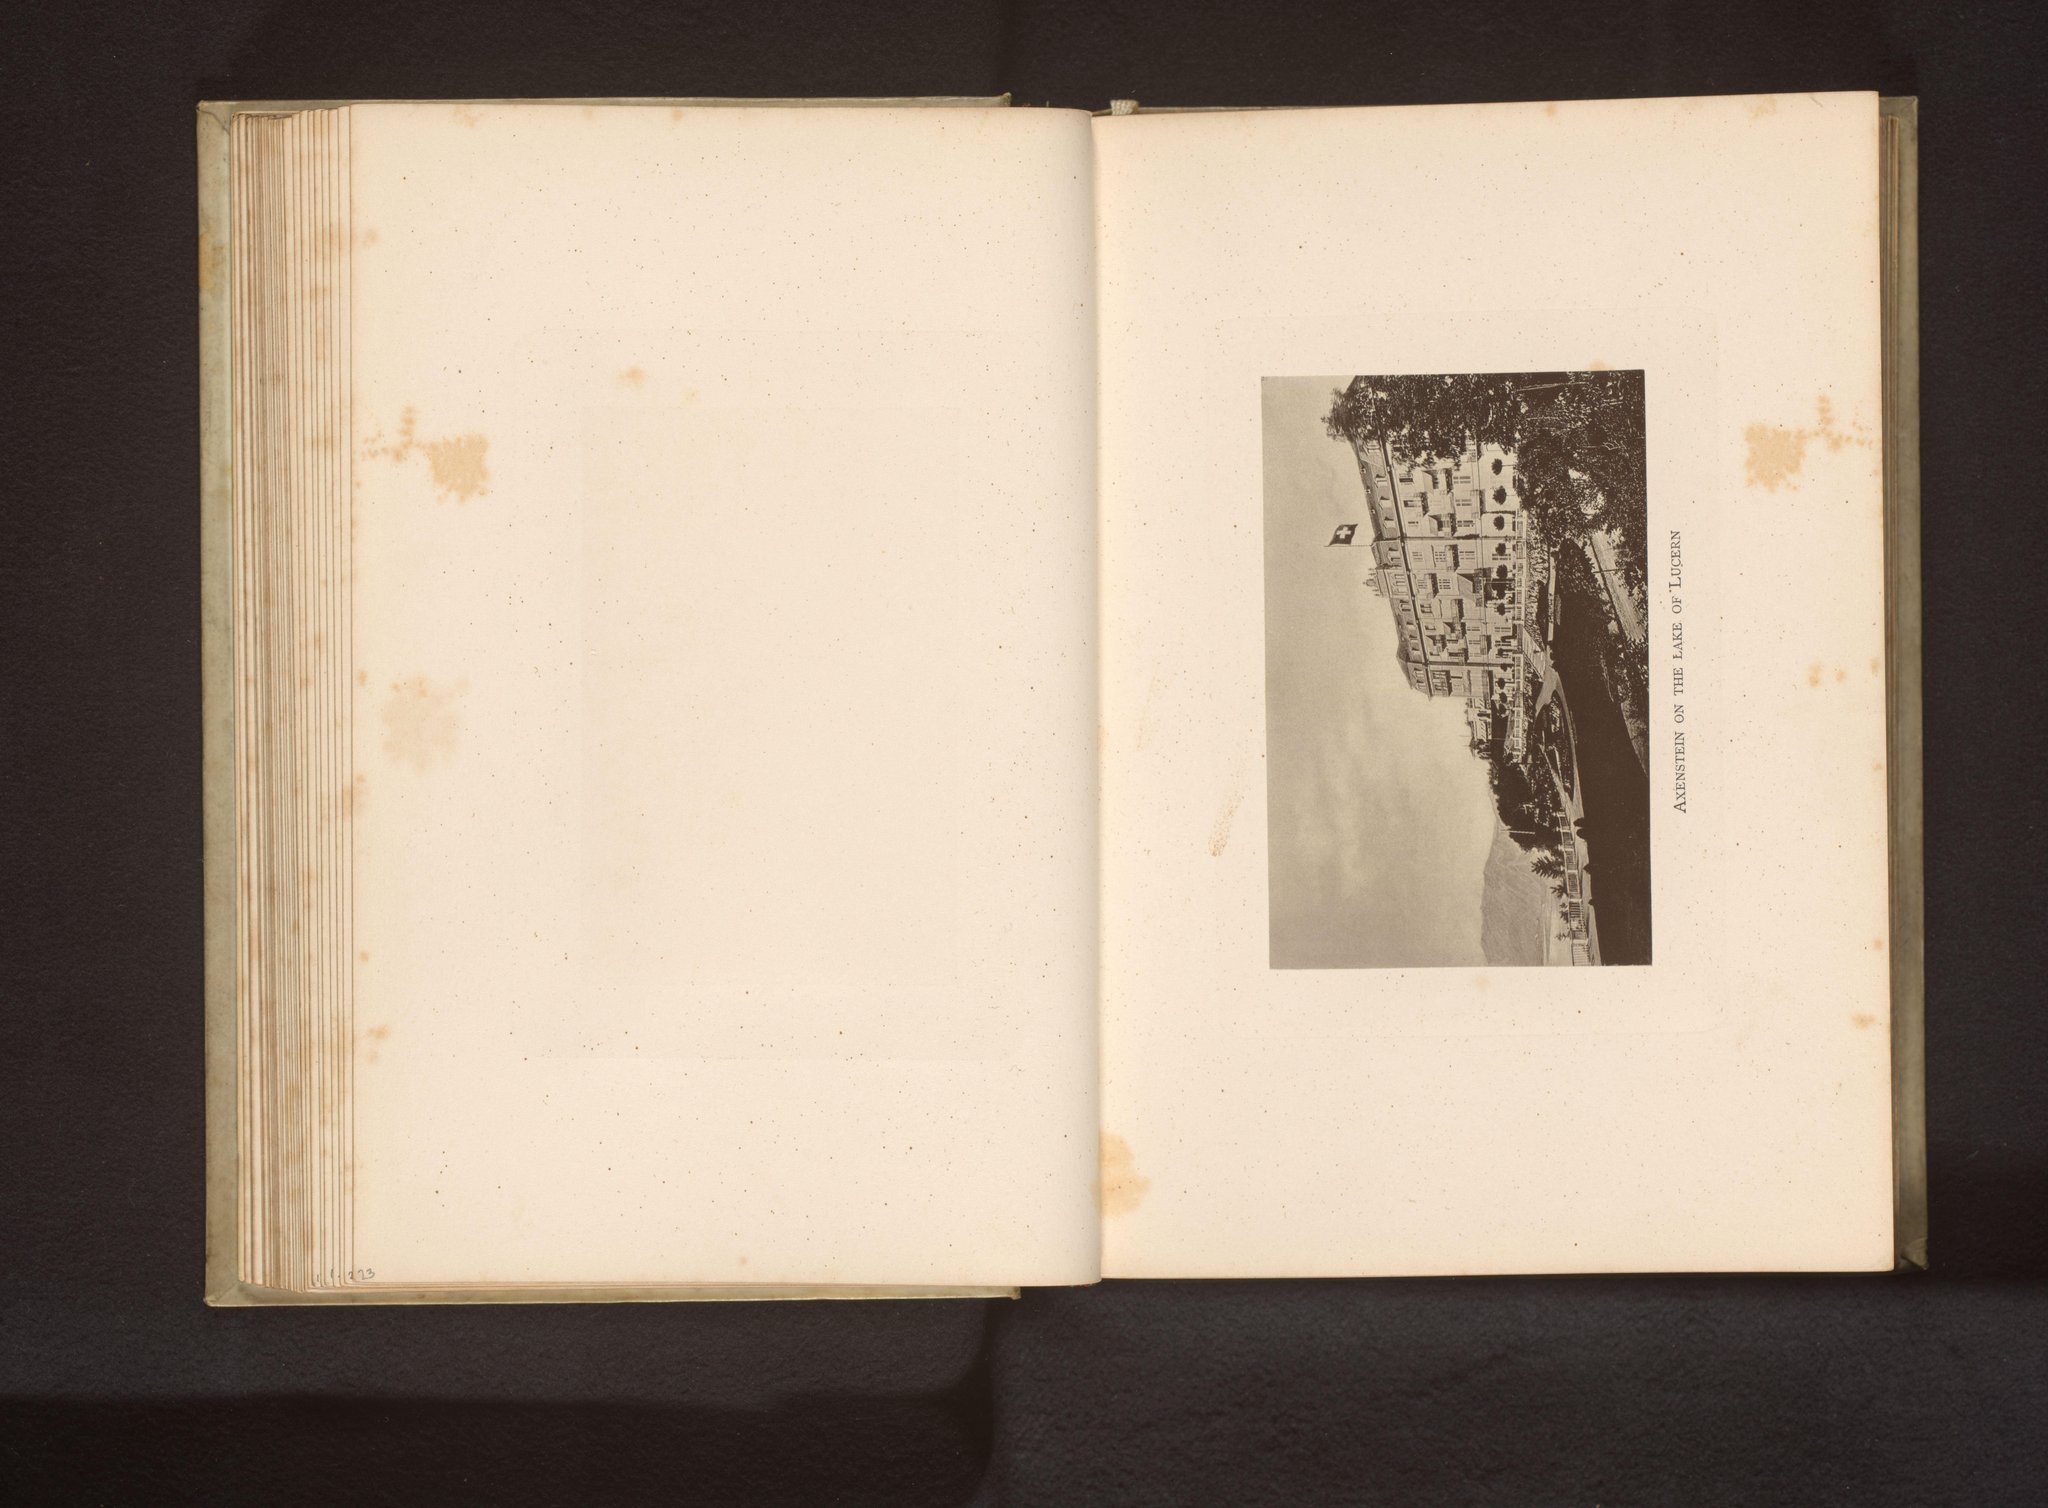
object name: page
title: Hotel Axenstein aan het Vierwoudstrekenmeer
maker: Anonymous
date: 1874-1884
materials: paper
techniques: photograph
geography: switzerland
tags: lake, hotel, hostelry, inn